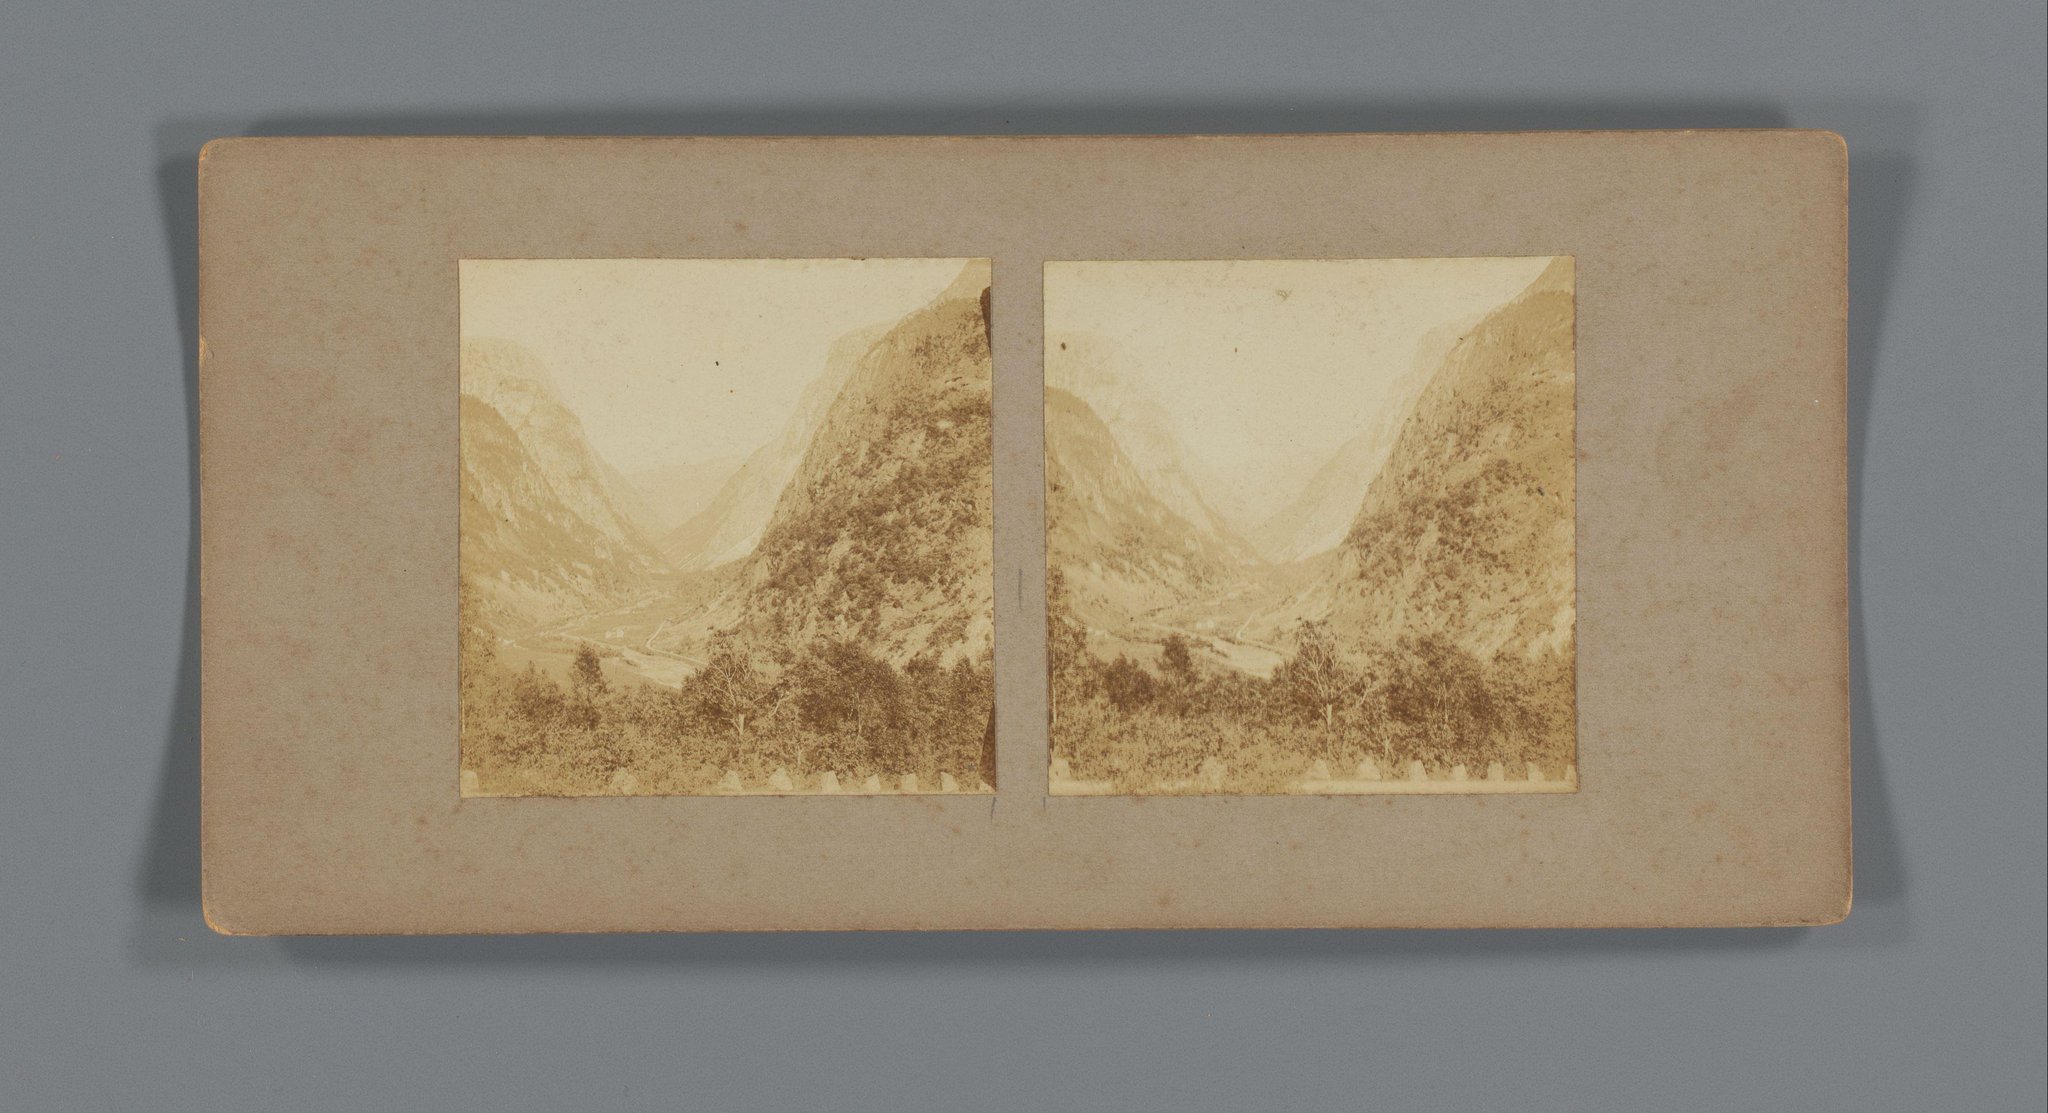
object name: stereograph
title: Gezicht op het Nærøydal bij Stalheim, Noorwegen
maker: Anonymous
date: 1882-1890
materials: cardboard, photographic support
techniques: gelatin silver print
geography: stalheim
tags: dale, valley